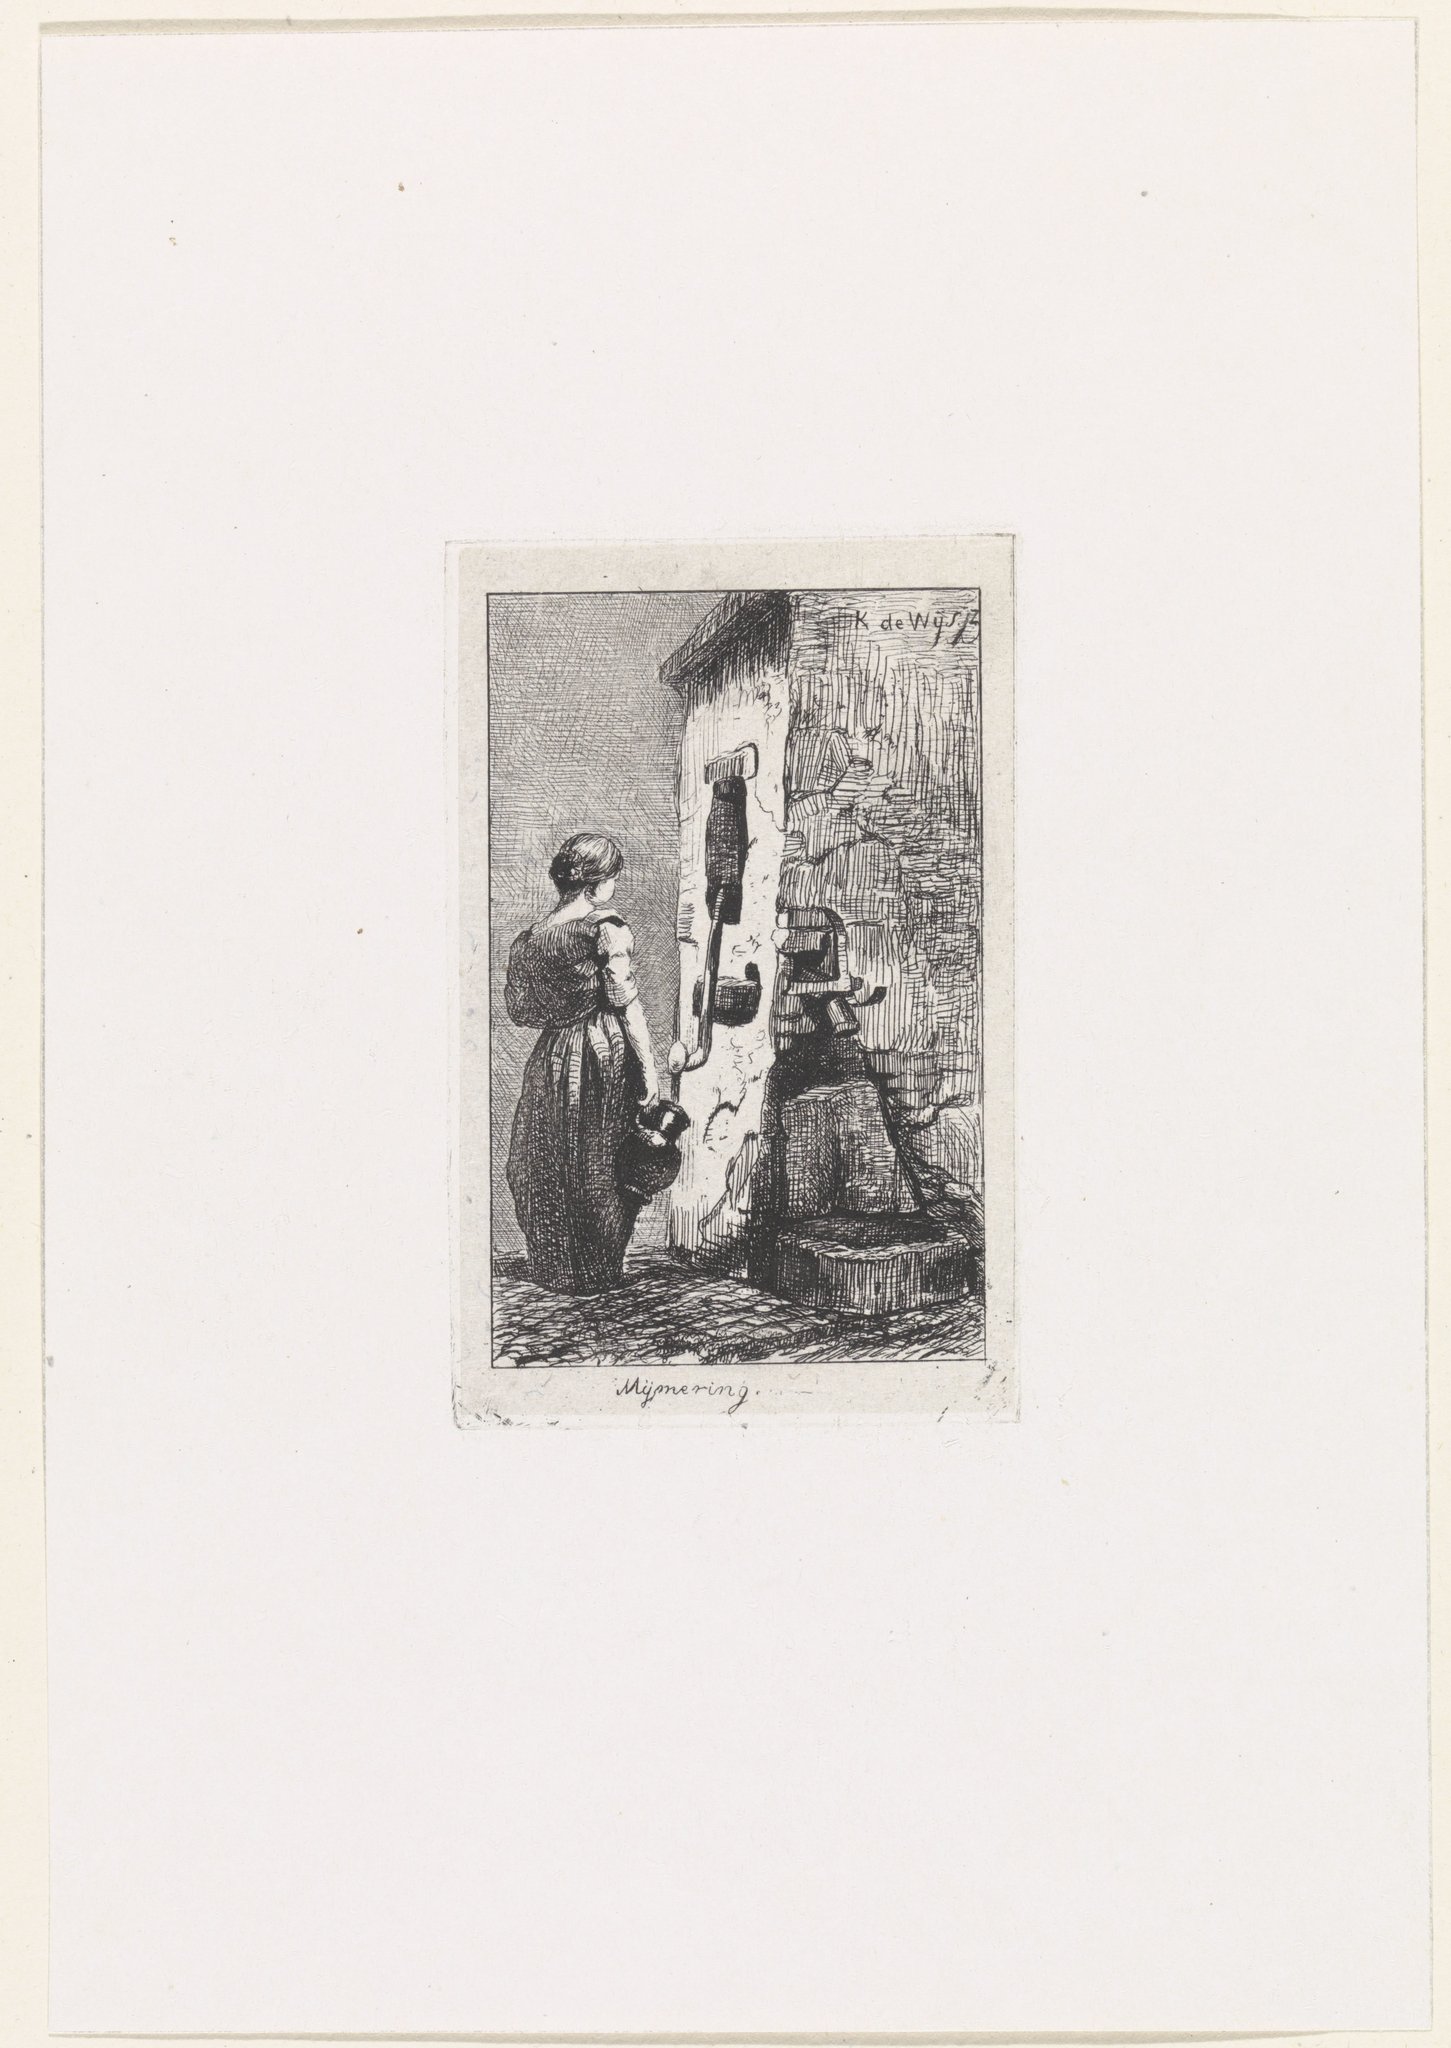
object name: print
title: Mijmering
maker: kornelis jzn de wijs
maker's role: print maker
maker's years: 1832-1896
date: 1842-1896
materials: paper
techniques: etching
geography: netherlands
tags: container of ceramics: jar, jug, pot, vase, utilitarian, public pump or water fountain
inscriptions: collector's mark: Lugt 2228, collector's mark: Lugt 2760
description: Een jonge vrouw staat in gedachten verzonken met een kruik in de hand bij een waterpomp.